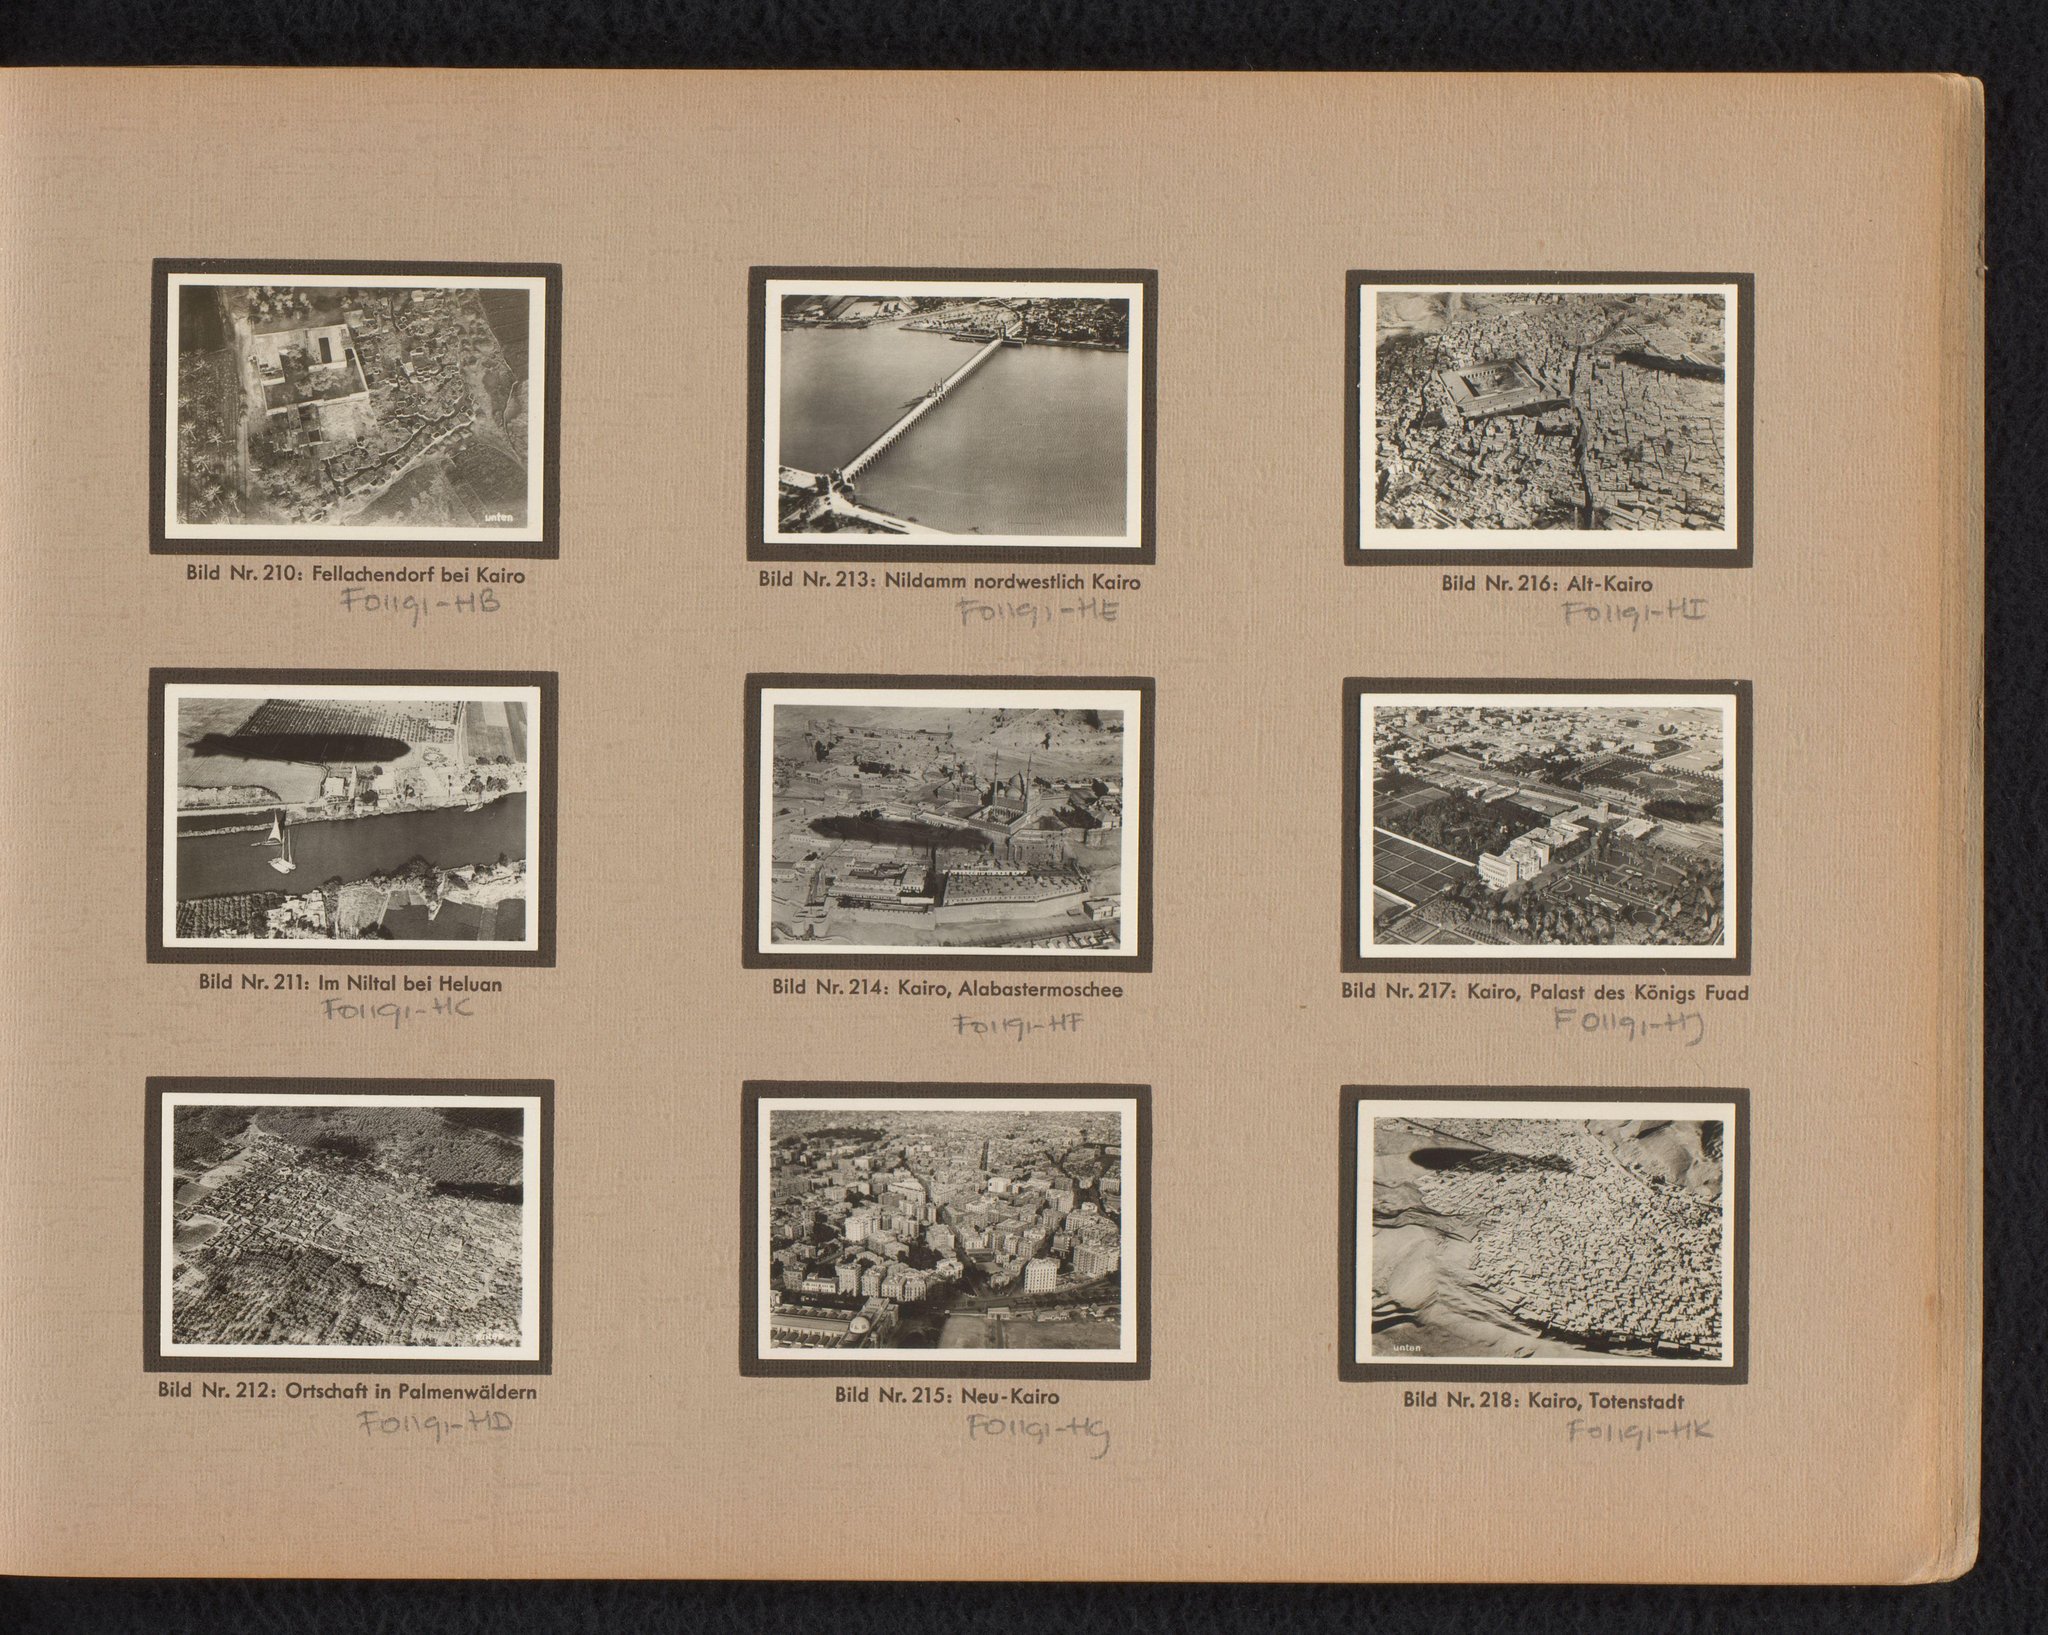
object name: album leaf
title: Uitzichten tijdens een vlucht naar Egypte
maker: Anonymous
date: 1930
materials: paper, photographic support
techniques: gelatin silver print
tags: shadow of an object, city-view, and landscape with man-made constructions, river, temple, shrine ~ islam, mohammedanism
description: Negen foto's gemaakt tijdens een vlucht naar Egypte, waaronder gezichten op de Moskee van Mohammed Ali te Caïro en de Nijl. Op sommige foto's is de schaduw van de zeppelin te zien. Alle foto's zijn voorzien van een nummer en titel. Deze pagina maakt deel uit van een album.